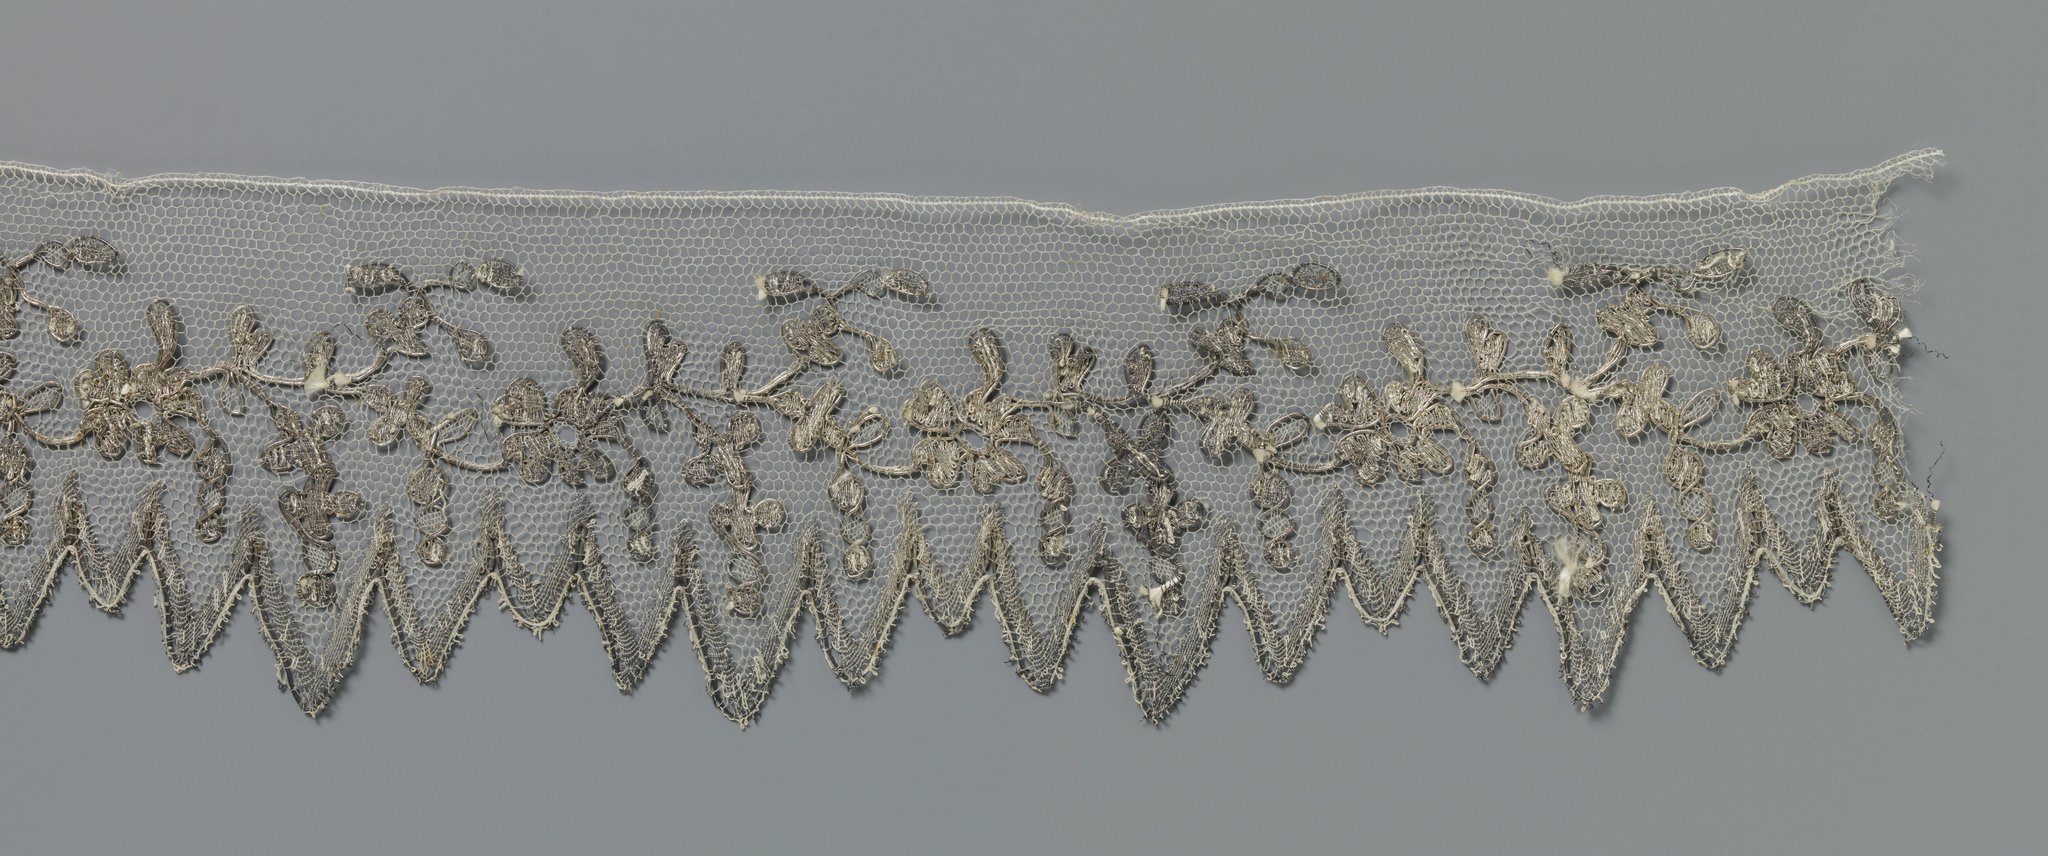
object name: strip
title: Strook kloskant en zilverkant met bloemenrank en afhangende bessen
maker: Anonymous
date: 1805-1815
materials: silk, thread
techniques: lace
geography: france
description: Strook kloskant, zilverkant, blonde. Op een maasgrond, een tulegrond van zijde, is met zilverdraad een zich herhalend en doorlopend patroon geklost van een bloemenrank met afhangende bessen. De bloemenrank loopt over de middenlijn van de strook en de bessen hangen met twee of drie onder elkaar naar benenden in de ongelijk zigzaggende schulpen langs de onderzijde van de strook. Voor het volwerk zijn dunnere filégaren gebruikt dan voor de dikke filégaren waarmee de contouren van de motieven en schulpen zijn benadrukt. De bovenzijde van de strook is recht afgewerkt, maar deels beschadigd. De zigzag-schulpen zijn afgewerkt met picots van zilverdraad.